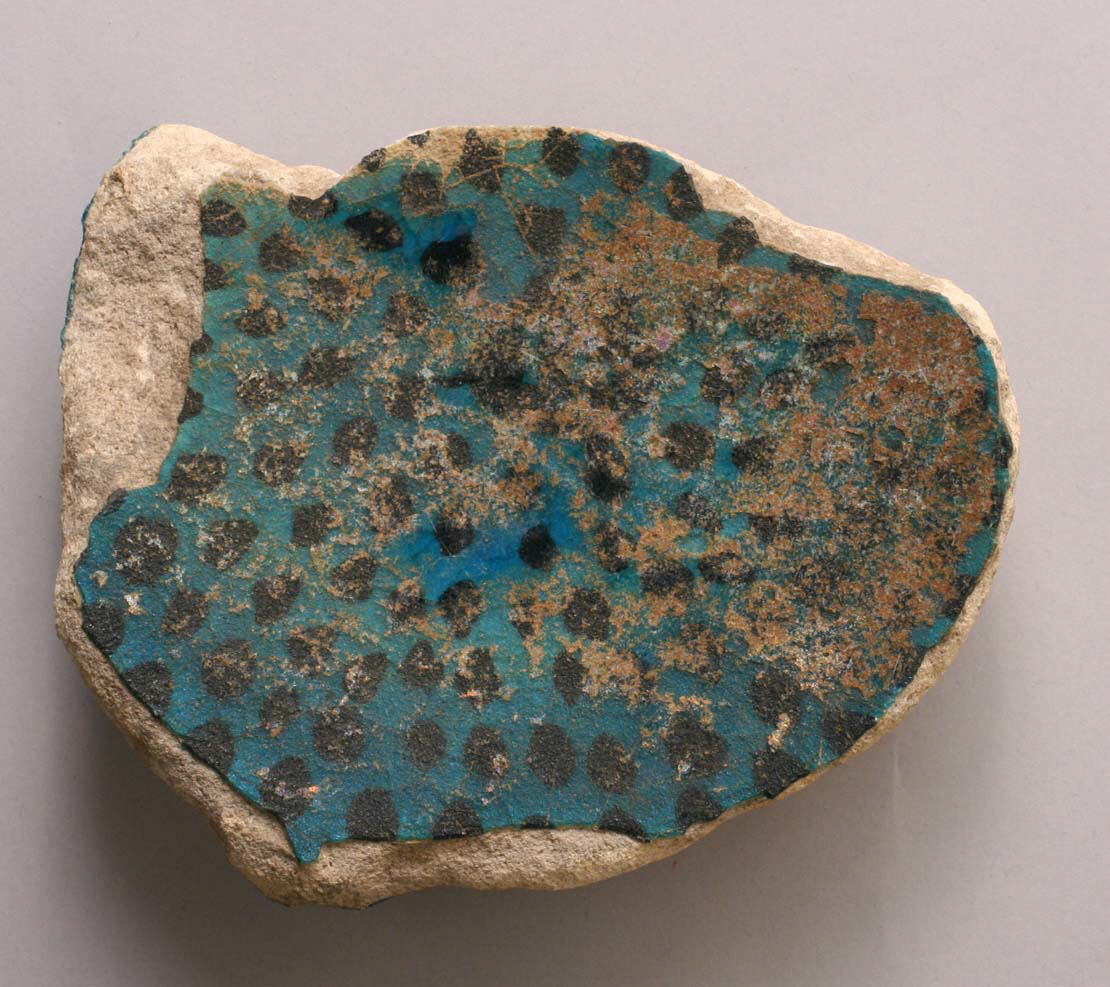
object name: fragment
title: Ceramic Fragment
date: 1201-1300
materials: glaze, stonepaste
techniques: painting, underglaze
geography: syria